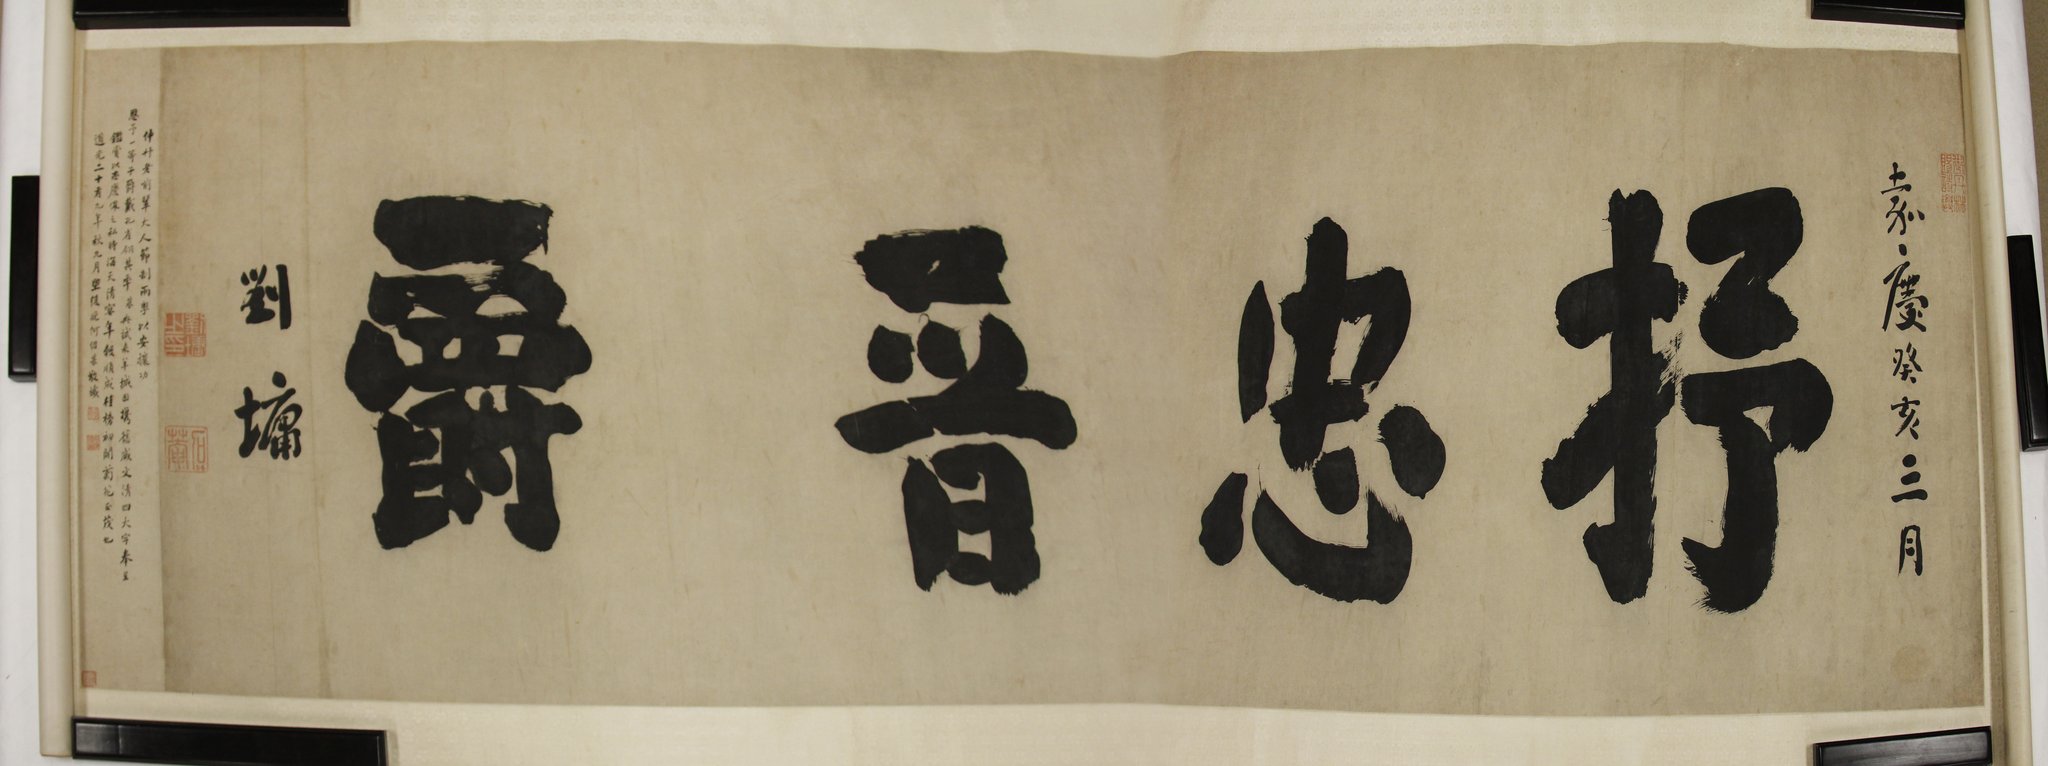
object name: hand scroll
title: Calligraphy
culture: chinese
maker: liu yong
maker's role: artist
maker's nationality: chinese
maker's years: 1719-1805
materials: ink, paper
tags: calligraphy